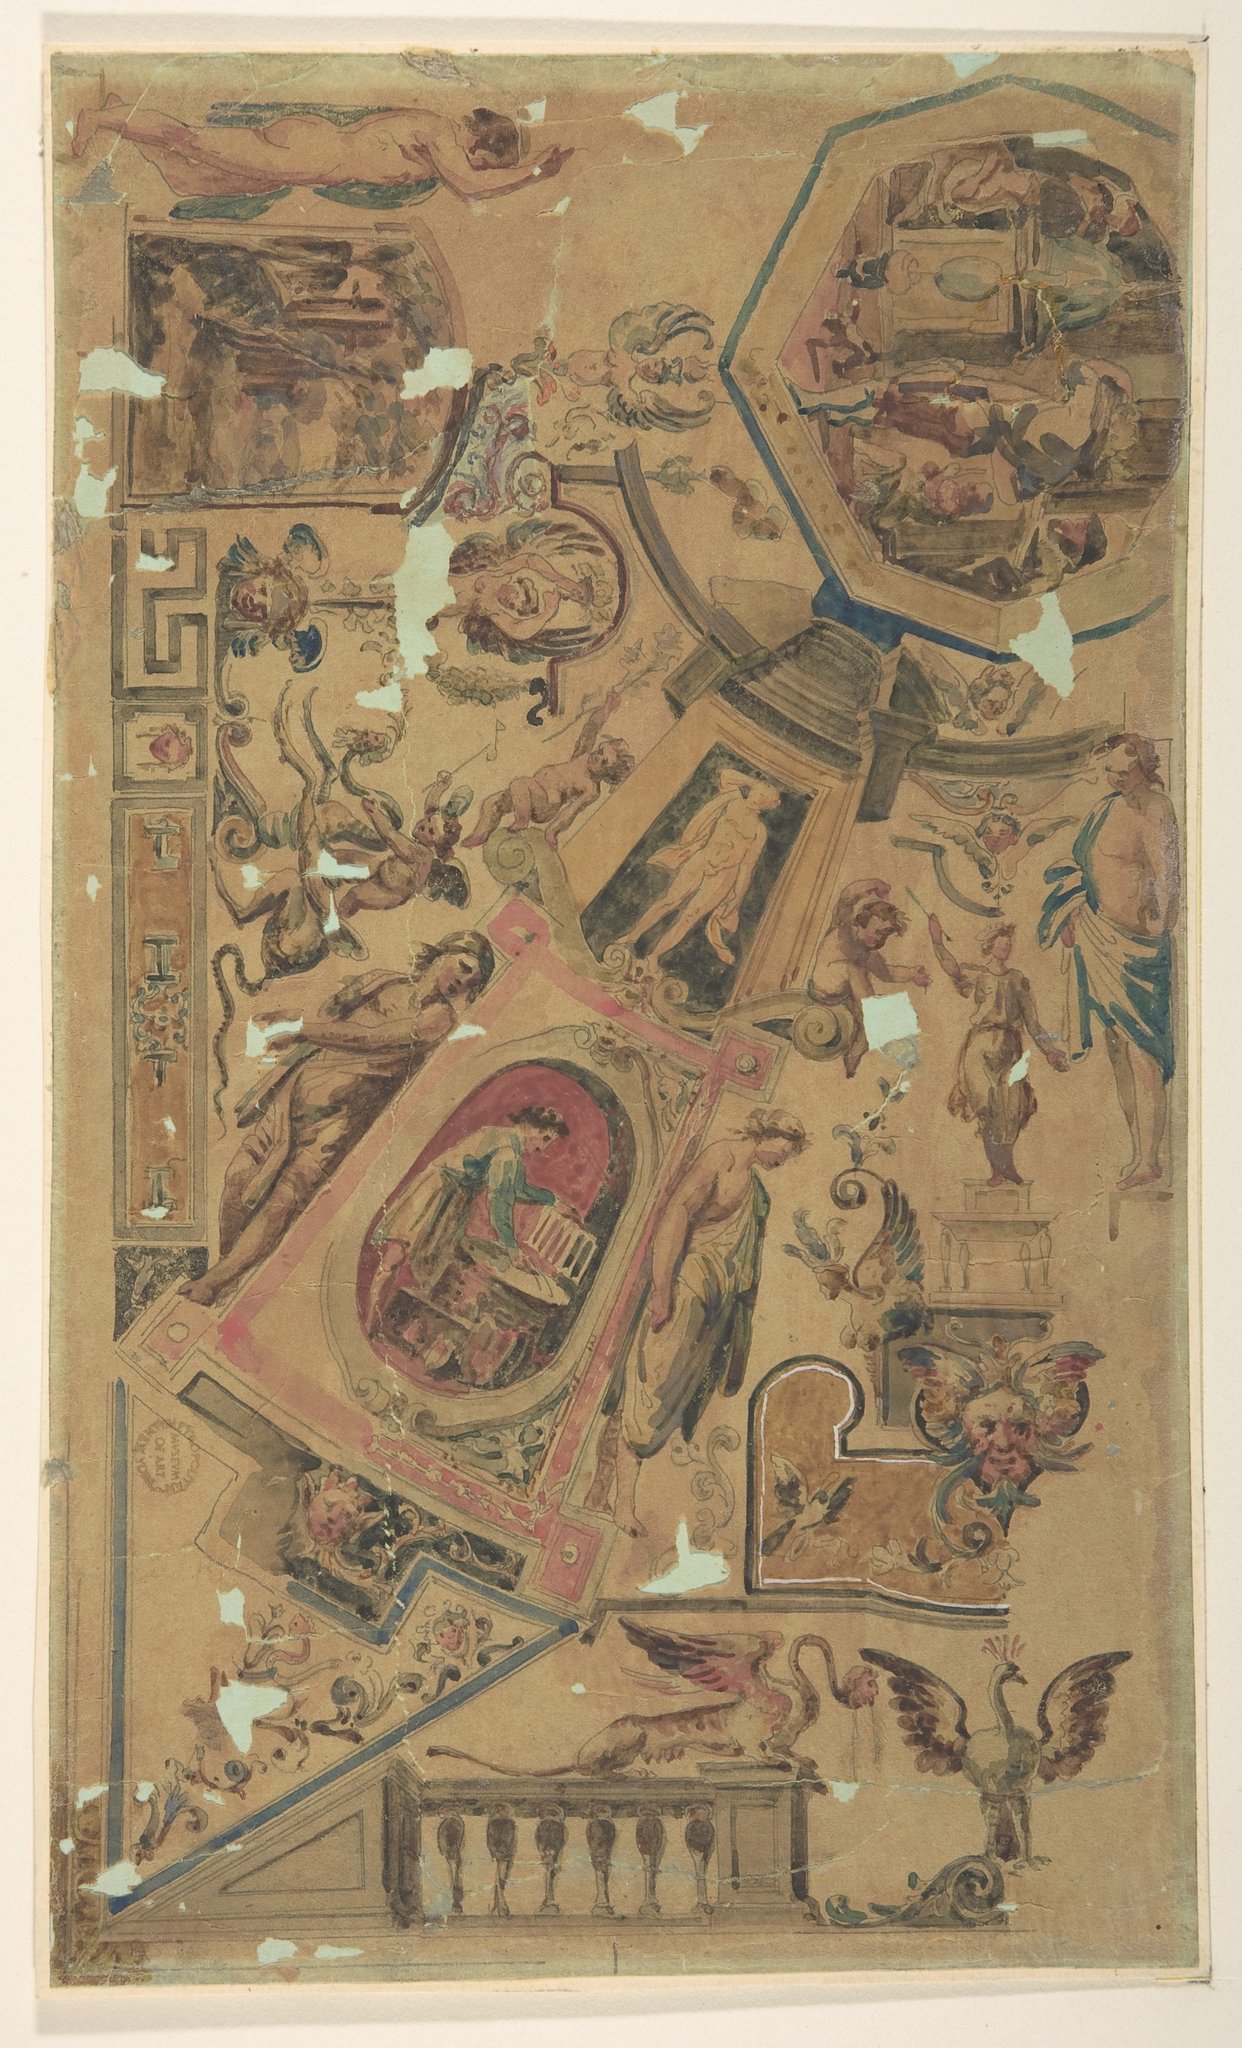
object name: drawing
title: Design for a Ceiling Decoration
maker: anonymous, italian, 19th century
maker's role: artist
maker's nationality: italian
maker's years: 1800-1900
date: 1800-1900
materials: pencil, watercolor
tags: birds,men,women,putti,ceilings